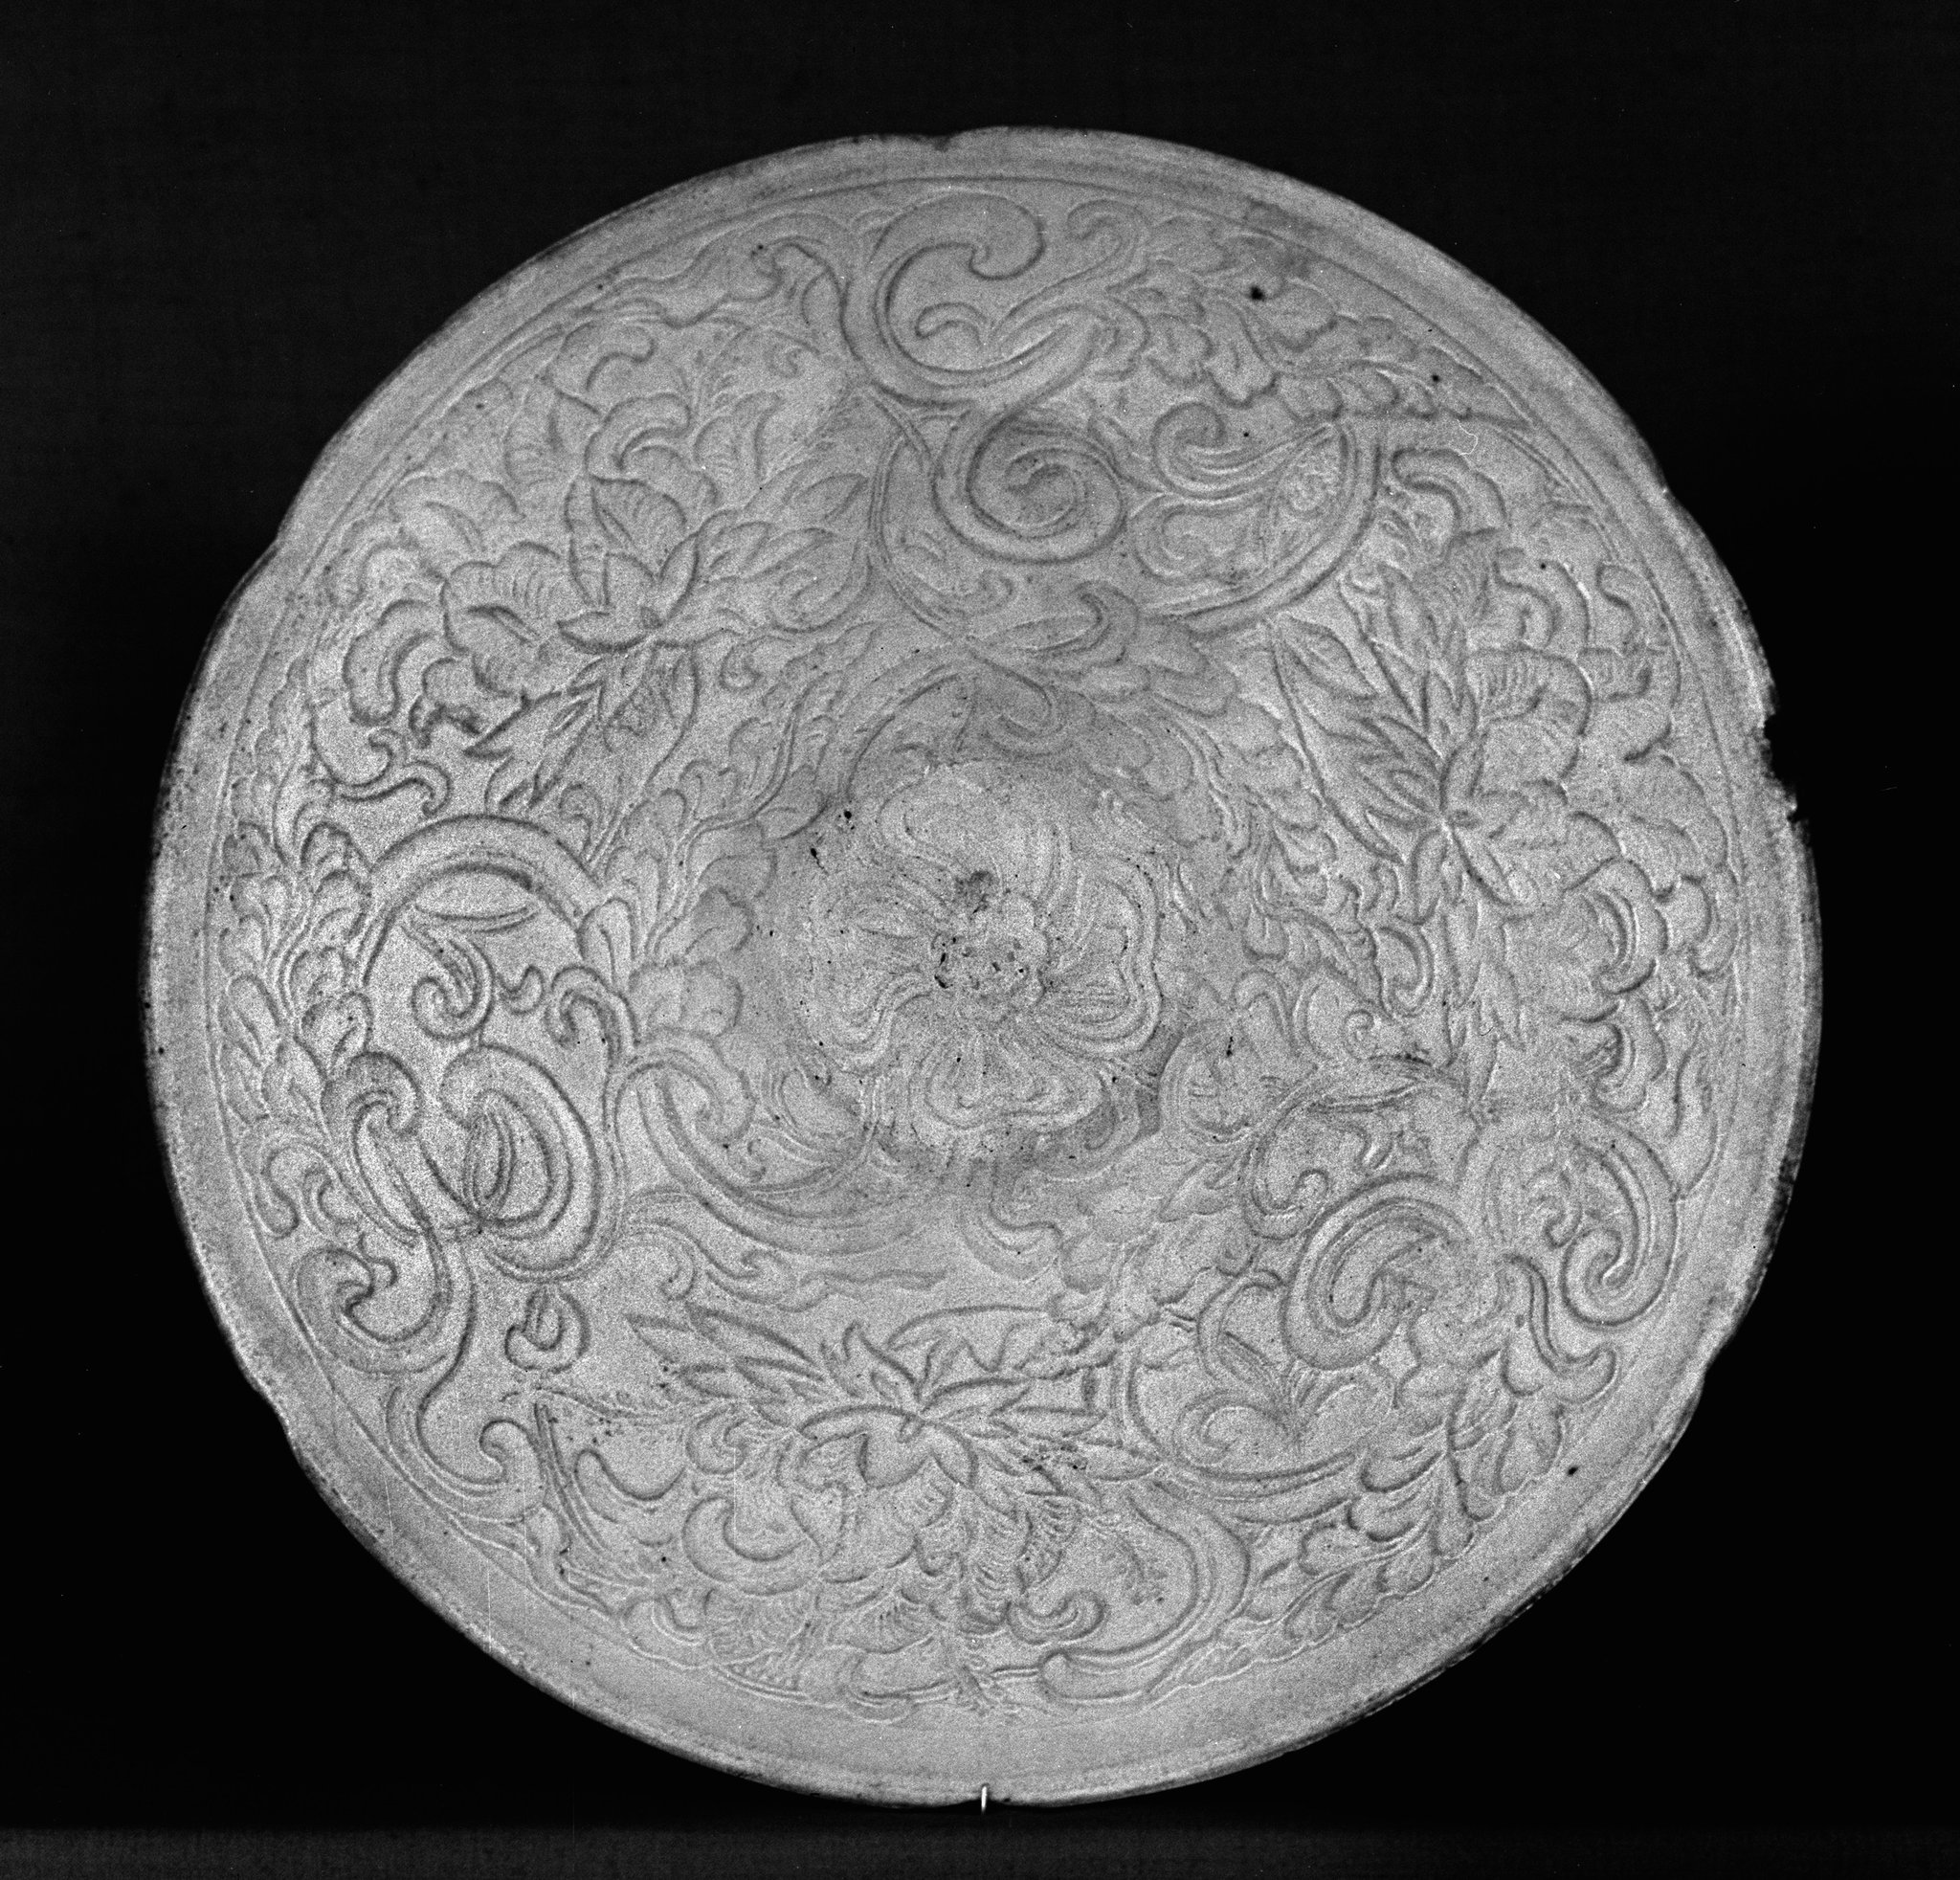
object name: bowl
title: Bowl with floral scrolls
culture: chinese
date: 1201-1400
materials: porcelain